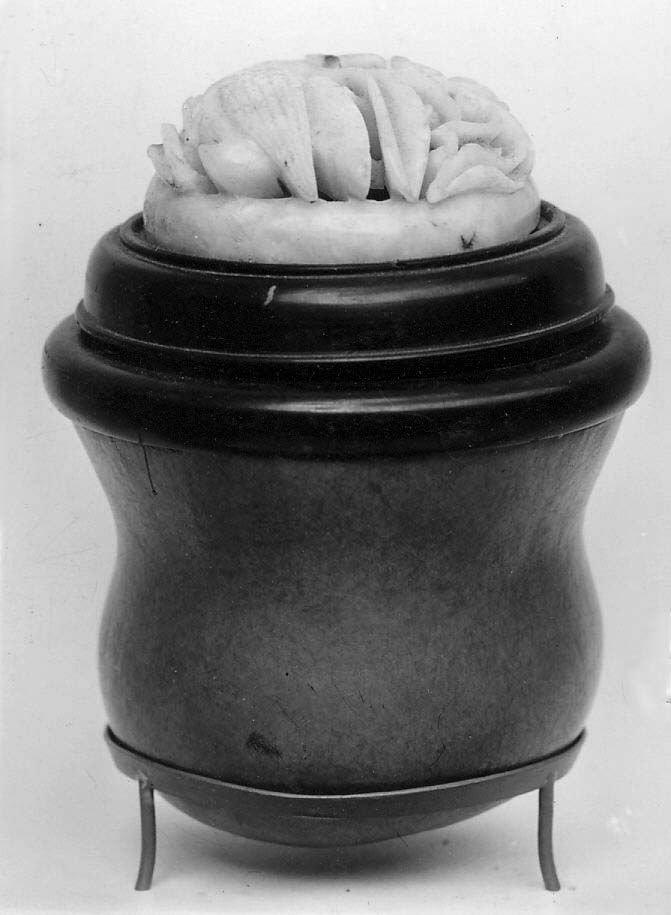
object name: cricket cage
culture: chinese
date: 1701-1900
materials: jade, wood